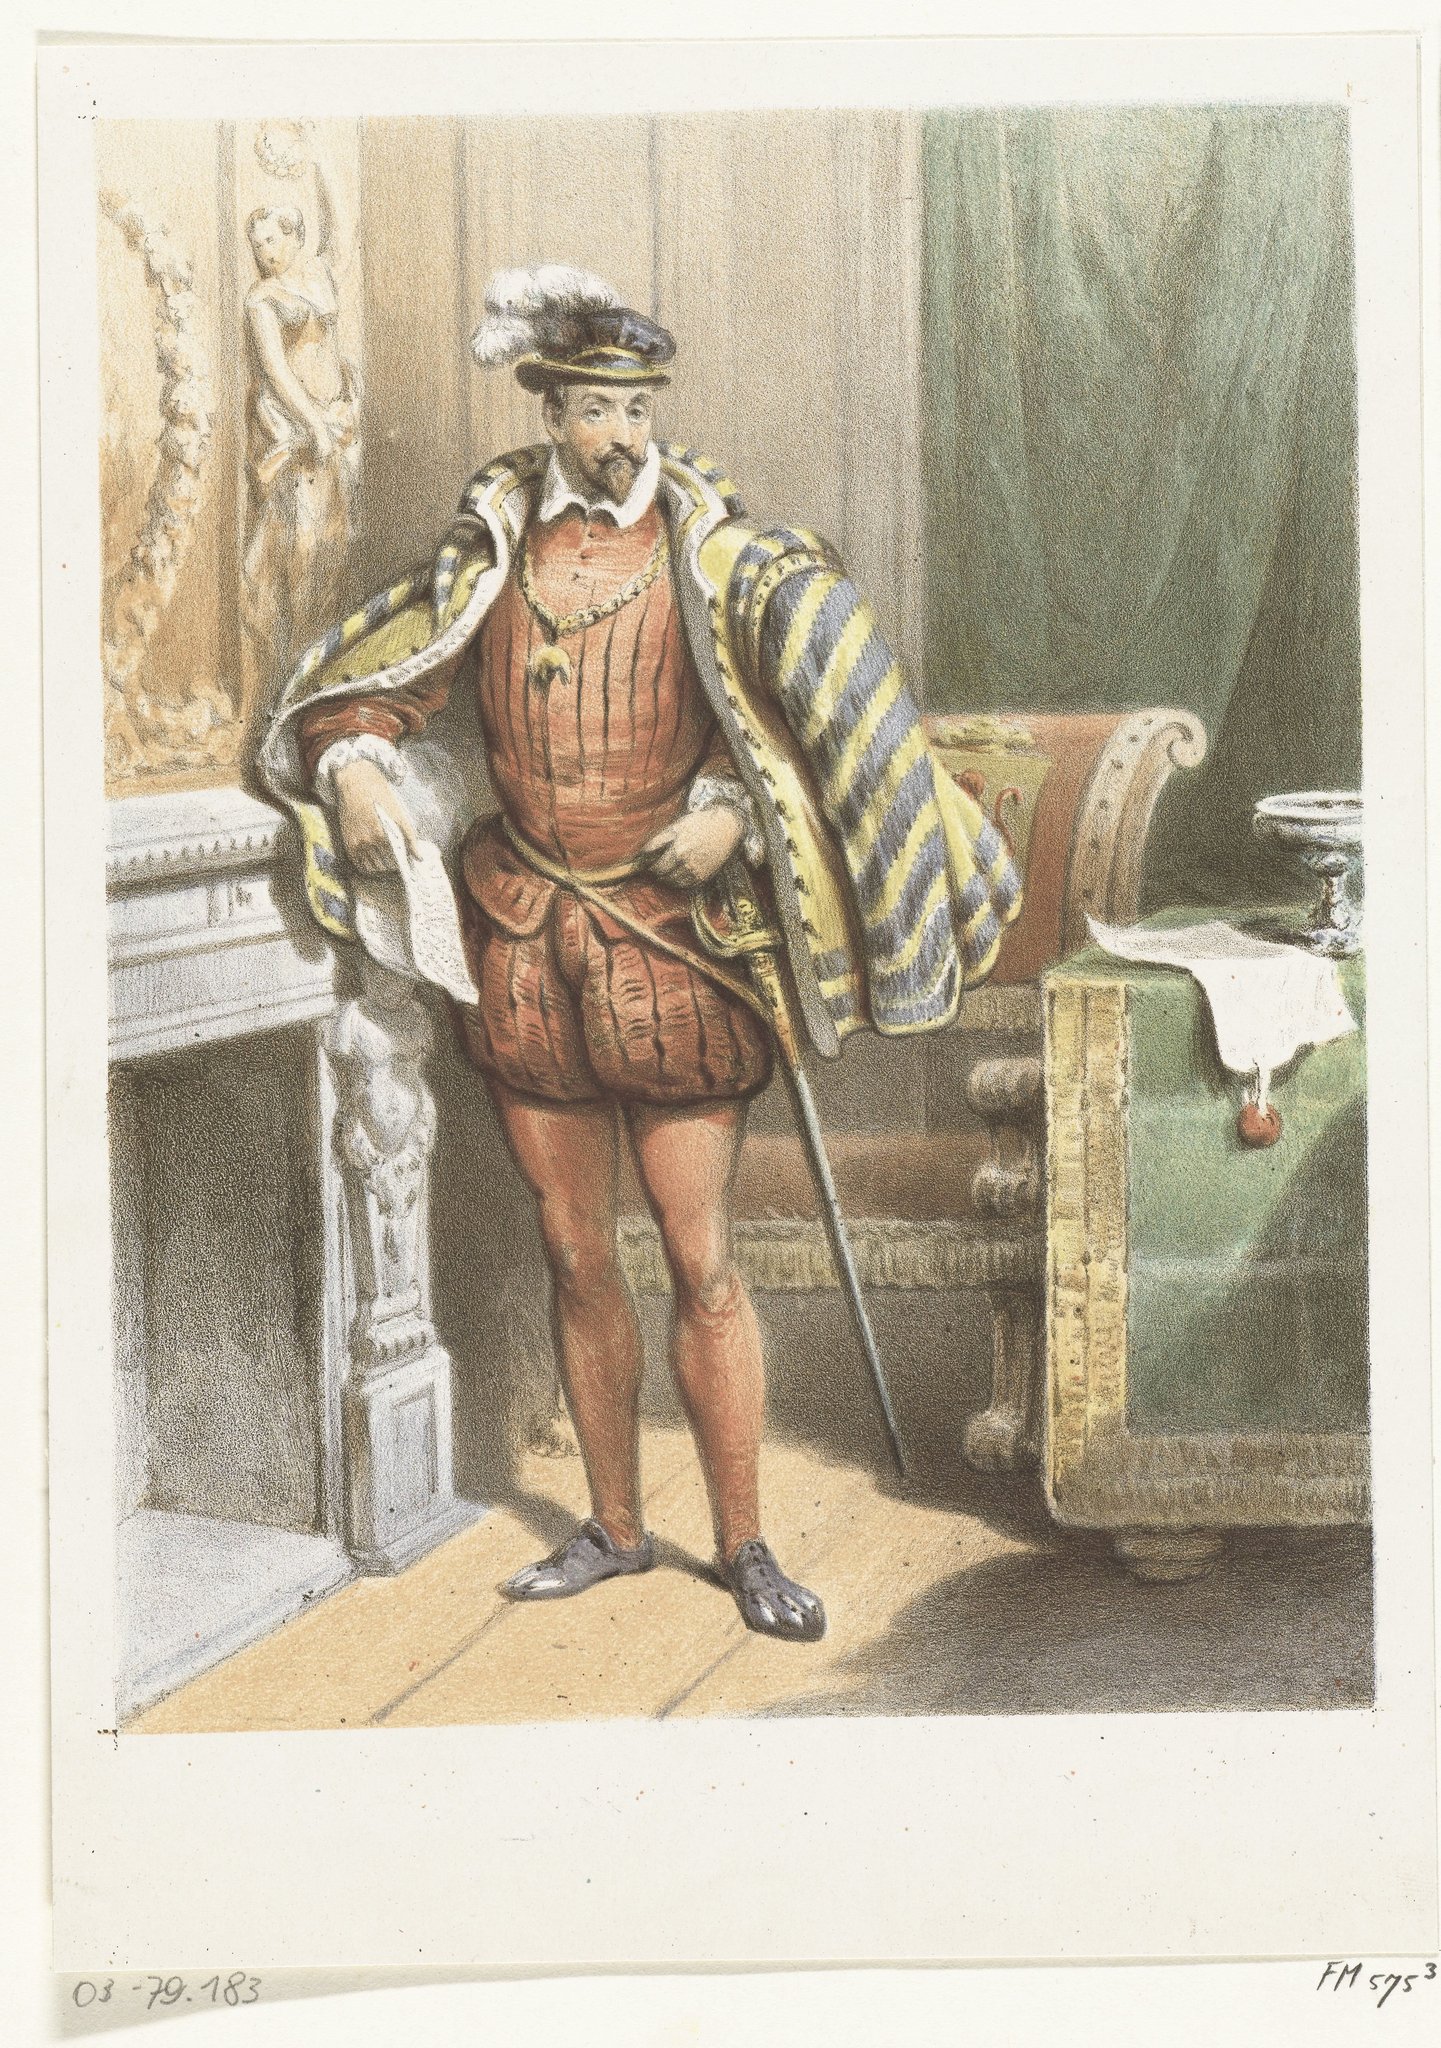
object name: history print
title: Portret van een staande edelman, ca. 1572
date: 1825-1899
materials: paper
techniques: chromolithography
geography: netherlands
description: Portret van een edelman met om de hals het ordeteken van het Gulden Vlies, staande met brief in de hand. Wellicht Willem van Oranje.